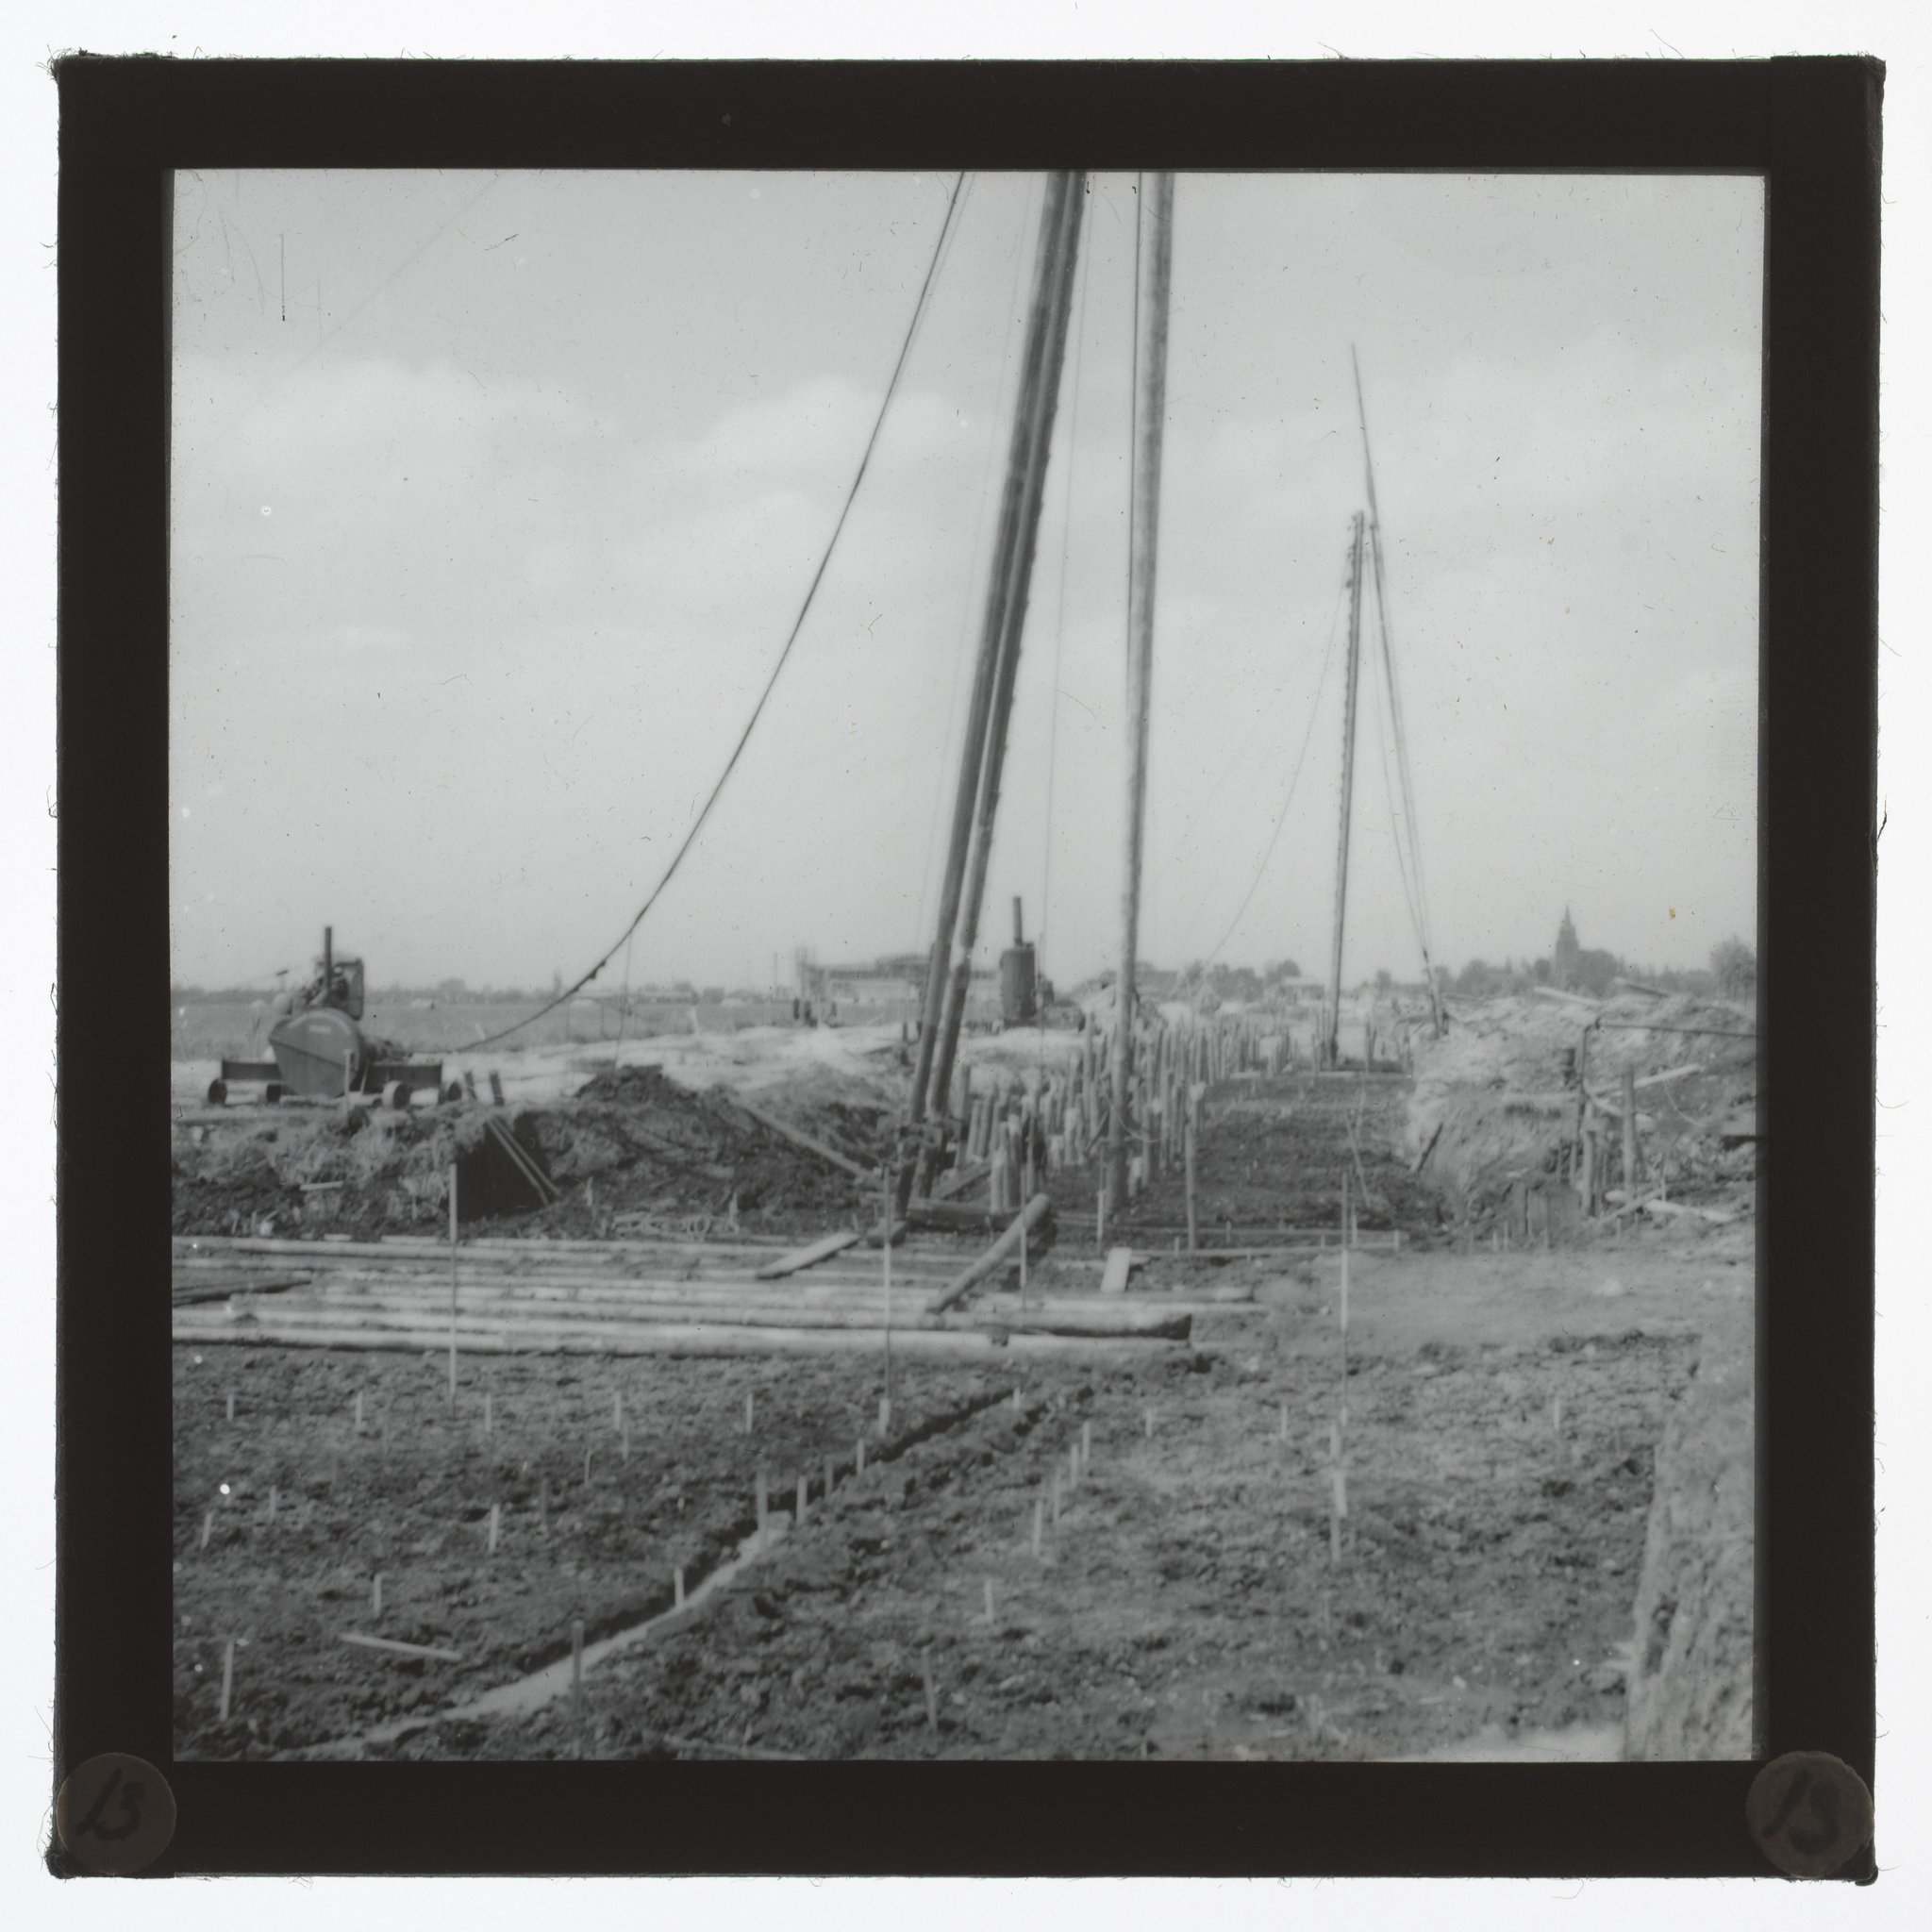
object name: lantern slide photographic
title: Gezicht op een bouwplaats, Zuid-Holland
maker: Anonymous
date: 1956-1960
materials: glass, paper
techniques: gelatin silver transparency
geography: south holland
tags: building-site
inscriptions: number: ‘13’